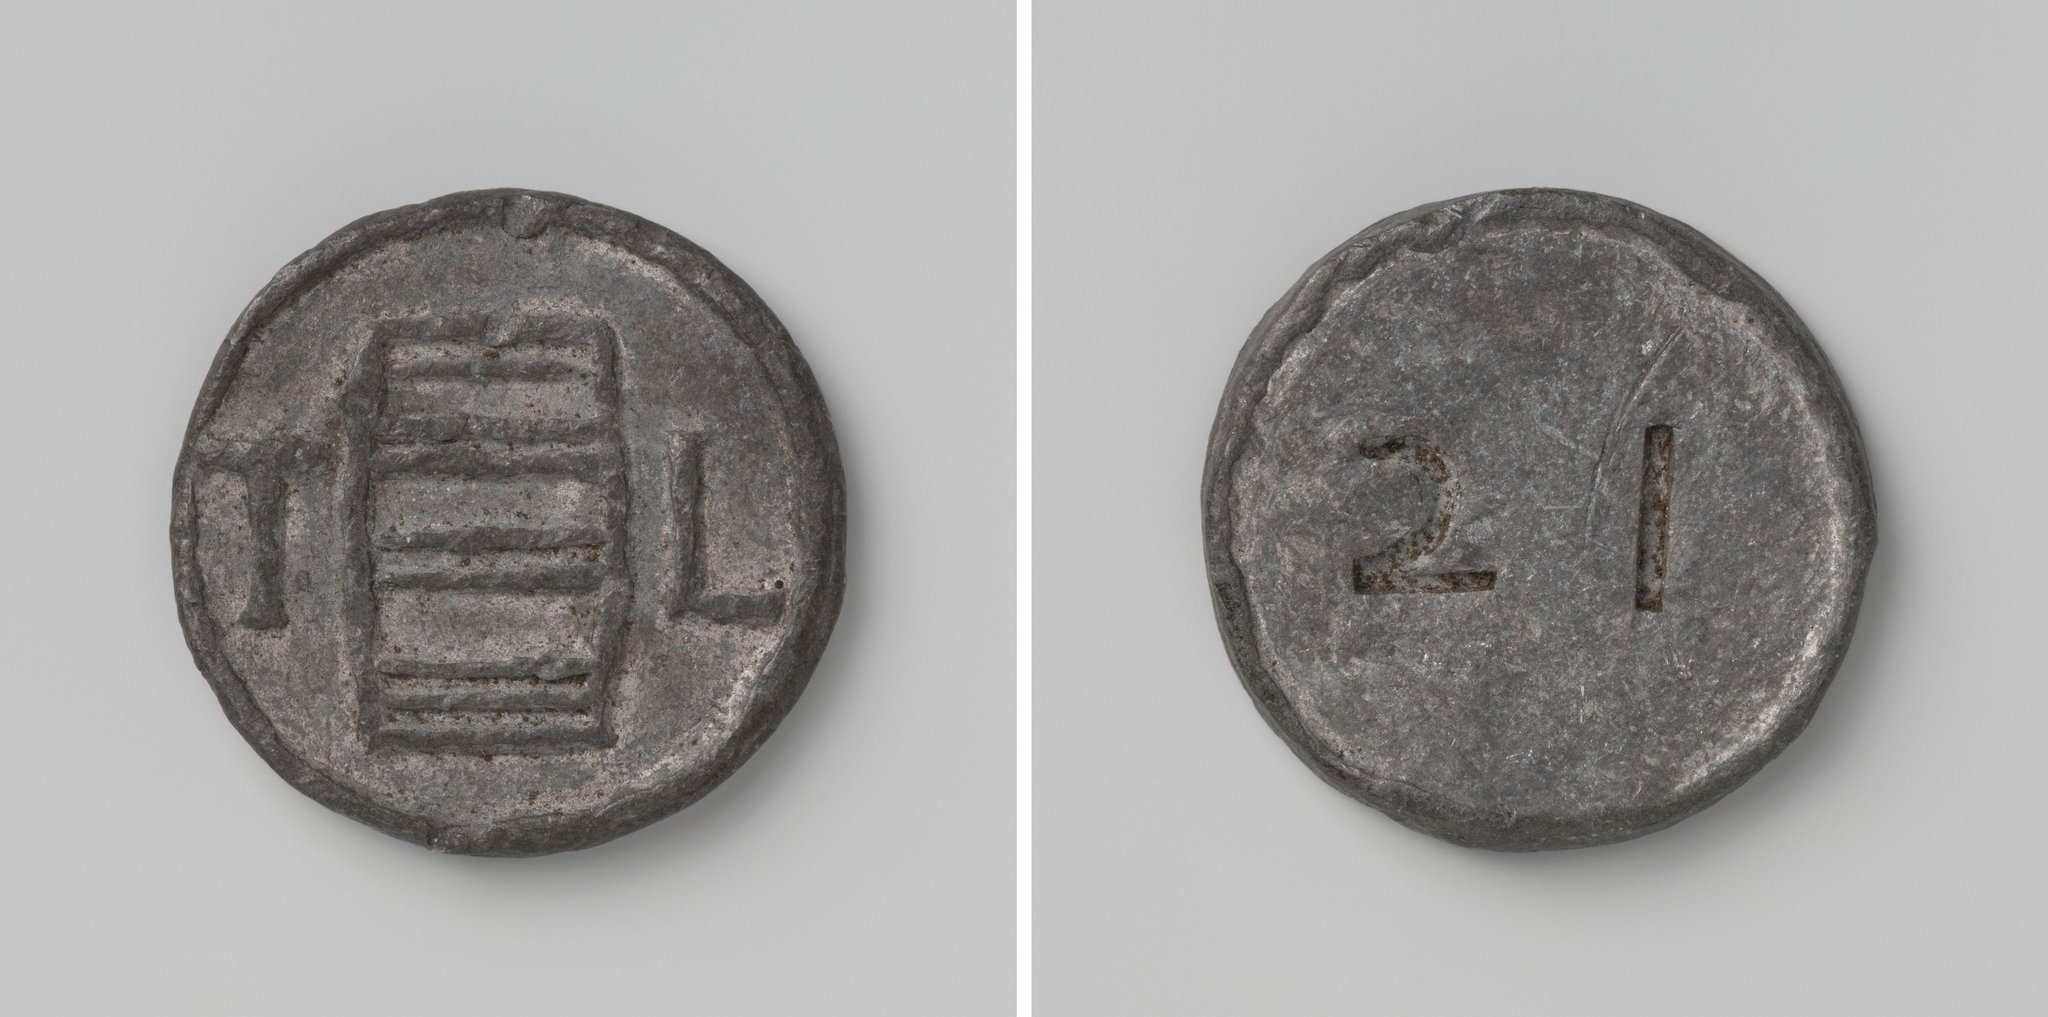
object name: medal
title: Turfdragersgilde van Amsterdam, gildepenning met no. 21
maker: Anonymous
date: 1600-1800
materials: lead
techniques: casting, engraving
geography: amsterdam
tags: amsterdam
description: Loden penning. Voorzijde: ton tussen letters T en L. Keerzijde: cijfer 21